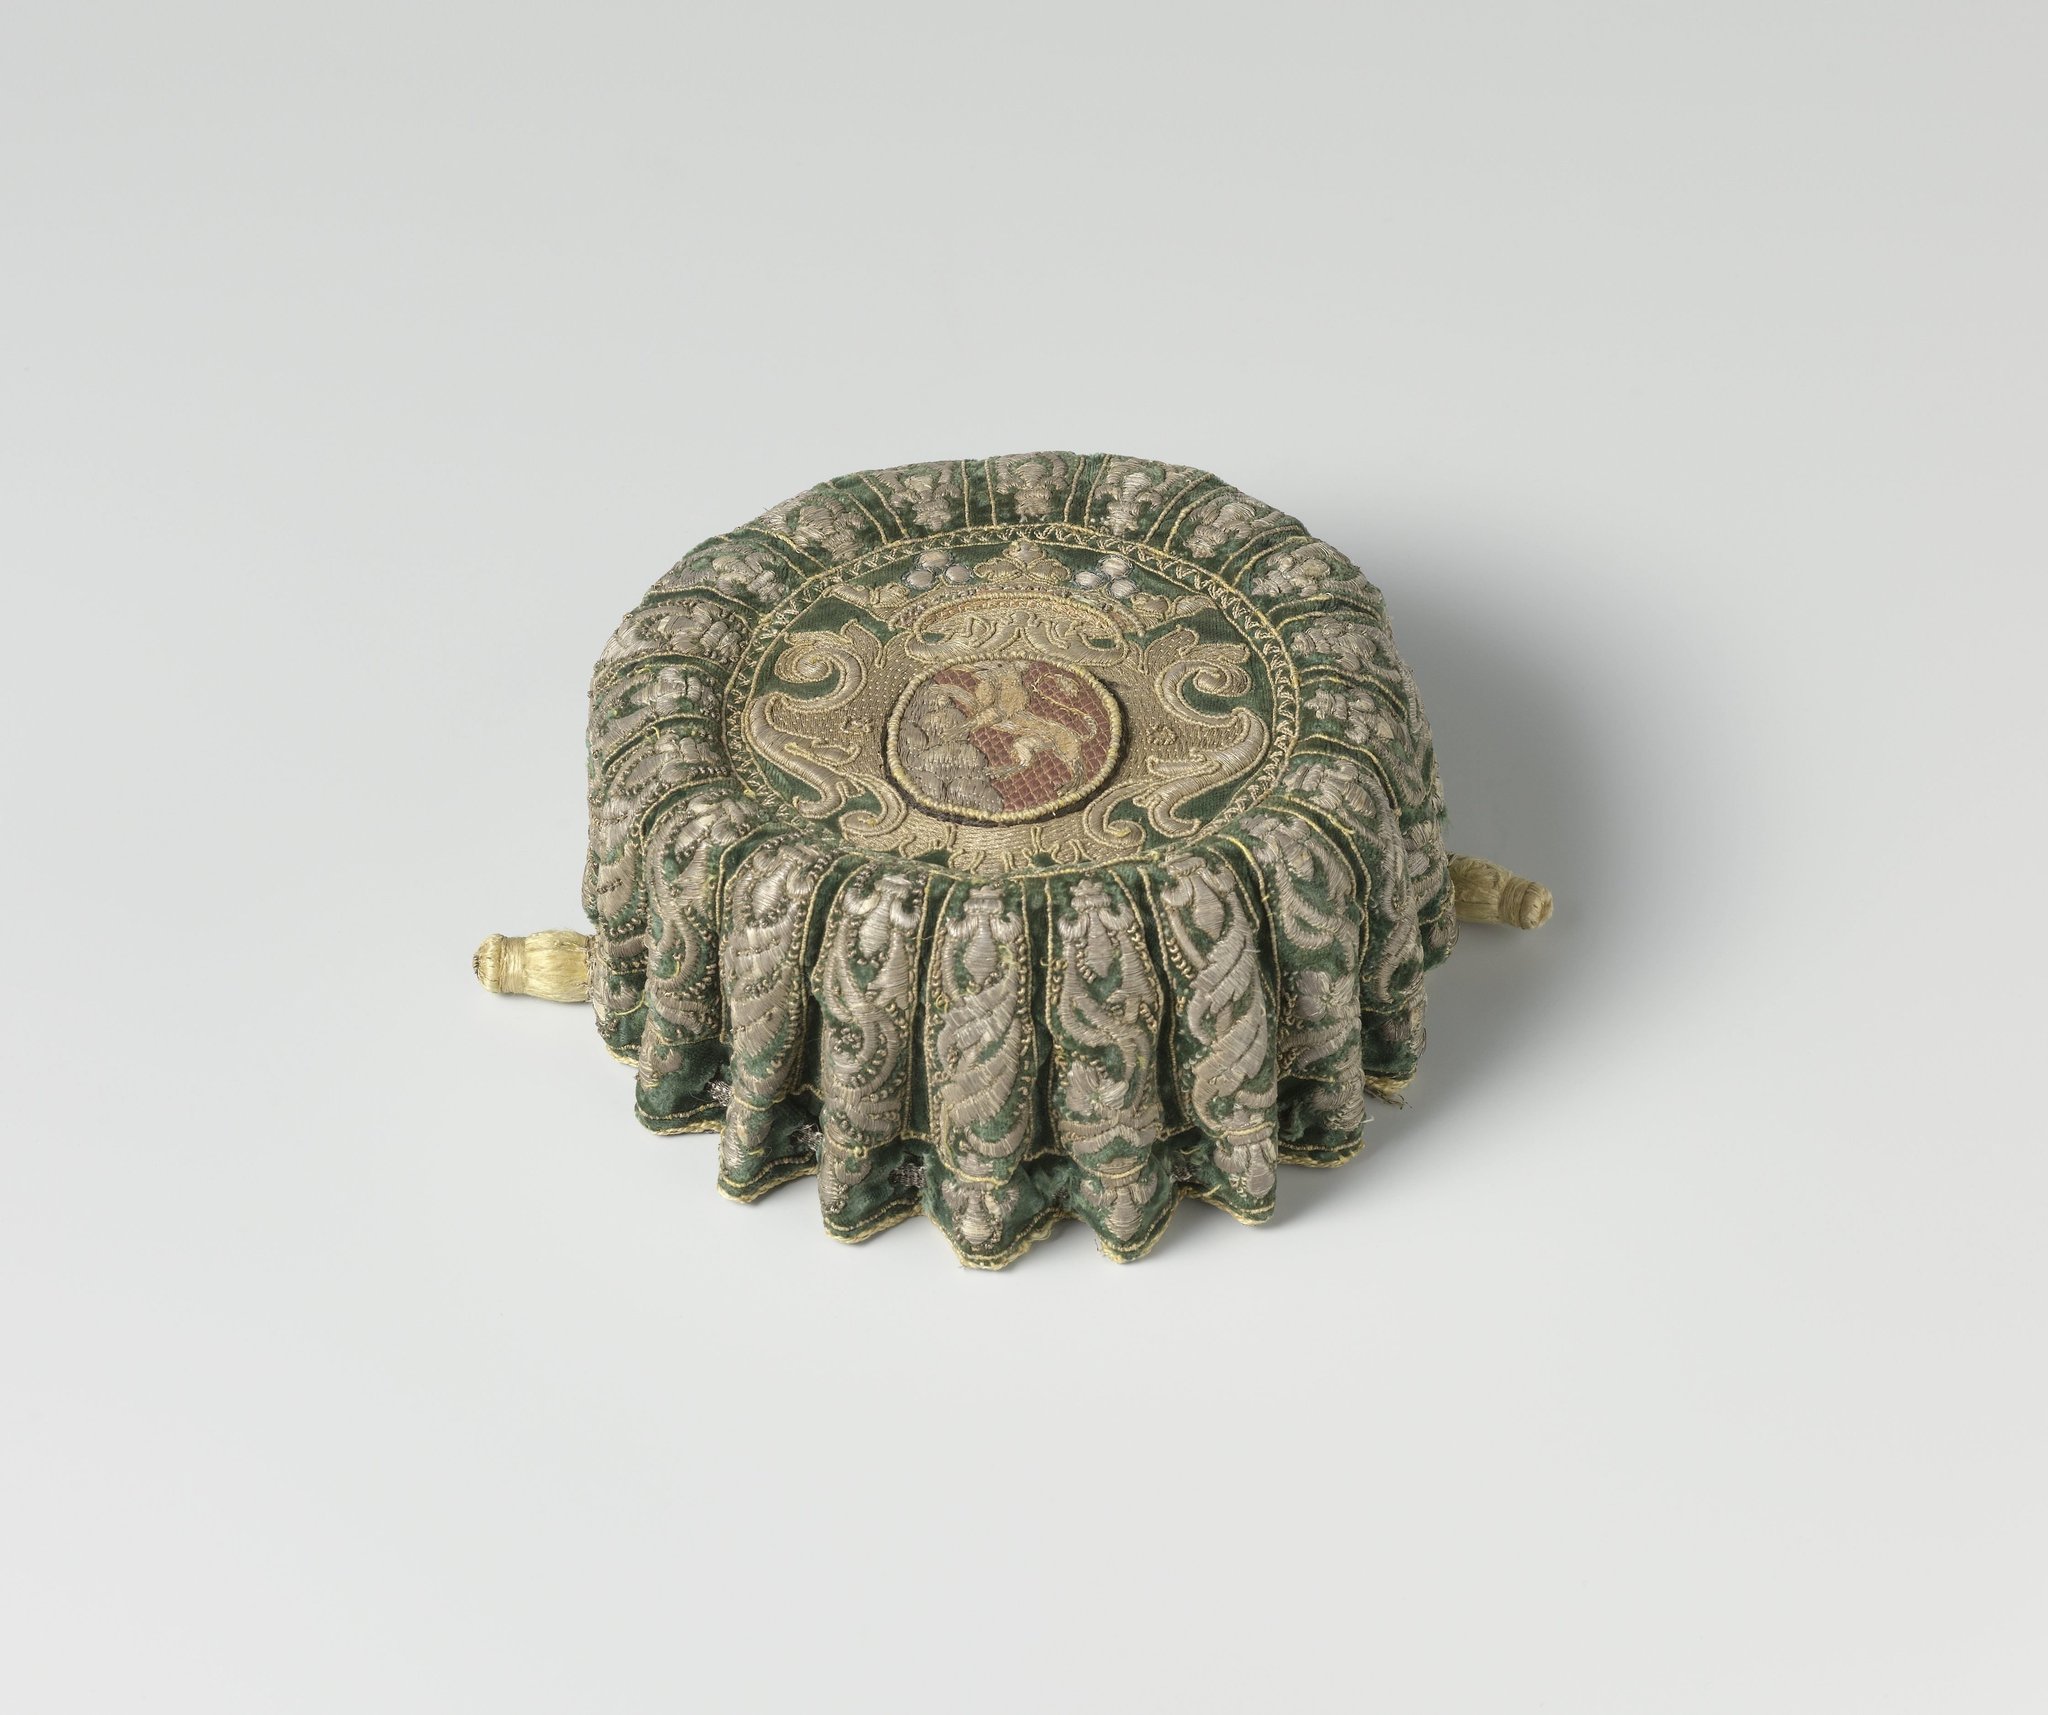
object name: speelbeurs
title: Speelbeurs van donkergroen fluweel, geborduurd in goud- en zilverdraad met het familiewapen Orry de Vignory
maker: Anonymous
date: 1685-1715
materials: leather, gold thread, parchment, thread, velvet, wood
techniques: embroidered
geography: france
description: Speelbeurs van donkergroen fluweel, geborduurd in goud- en zilverdraad met het familiewapen Orry de Vignory (ook: Vignori). Model: platte ronde bodem waar omheen een golvende opstaande rand voorzien gaten waardoor een trekkoord van zilverdraad loopt. Gevoerd met geitenleer. Versiering: de 20 uitstulpingen of 'ribben' zijn omlijnd met gouddraad. Hiertussen beurtelings een S-rank en aan acanthusspiraal. Aan de boven- en onderkant voorzien van een Franse lelie of 'fleur de lys'. De bodem wordt geheel gevuld door een lambrequin waarin een verhoogd geplaatst familiewapen waarboven een kroon in reliëf. Het wapen bestaat uit een klimmende leeuw van goud tegen een rots van zilver op een geruite purperen ondergrond. De leeuw komt van de heraldische rechterkant. Links en rechts is in het midden op de rand een met gele zijde omwonden houten kraal bevestigd. Het fluweel is afgezet met een gelust zilverdraad.